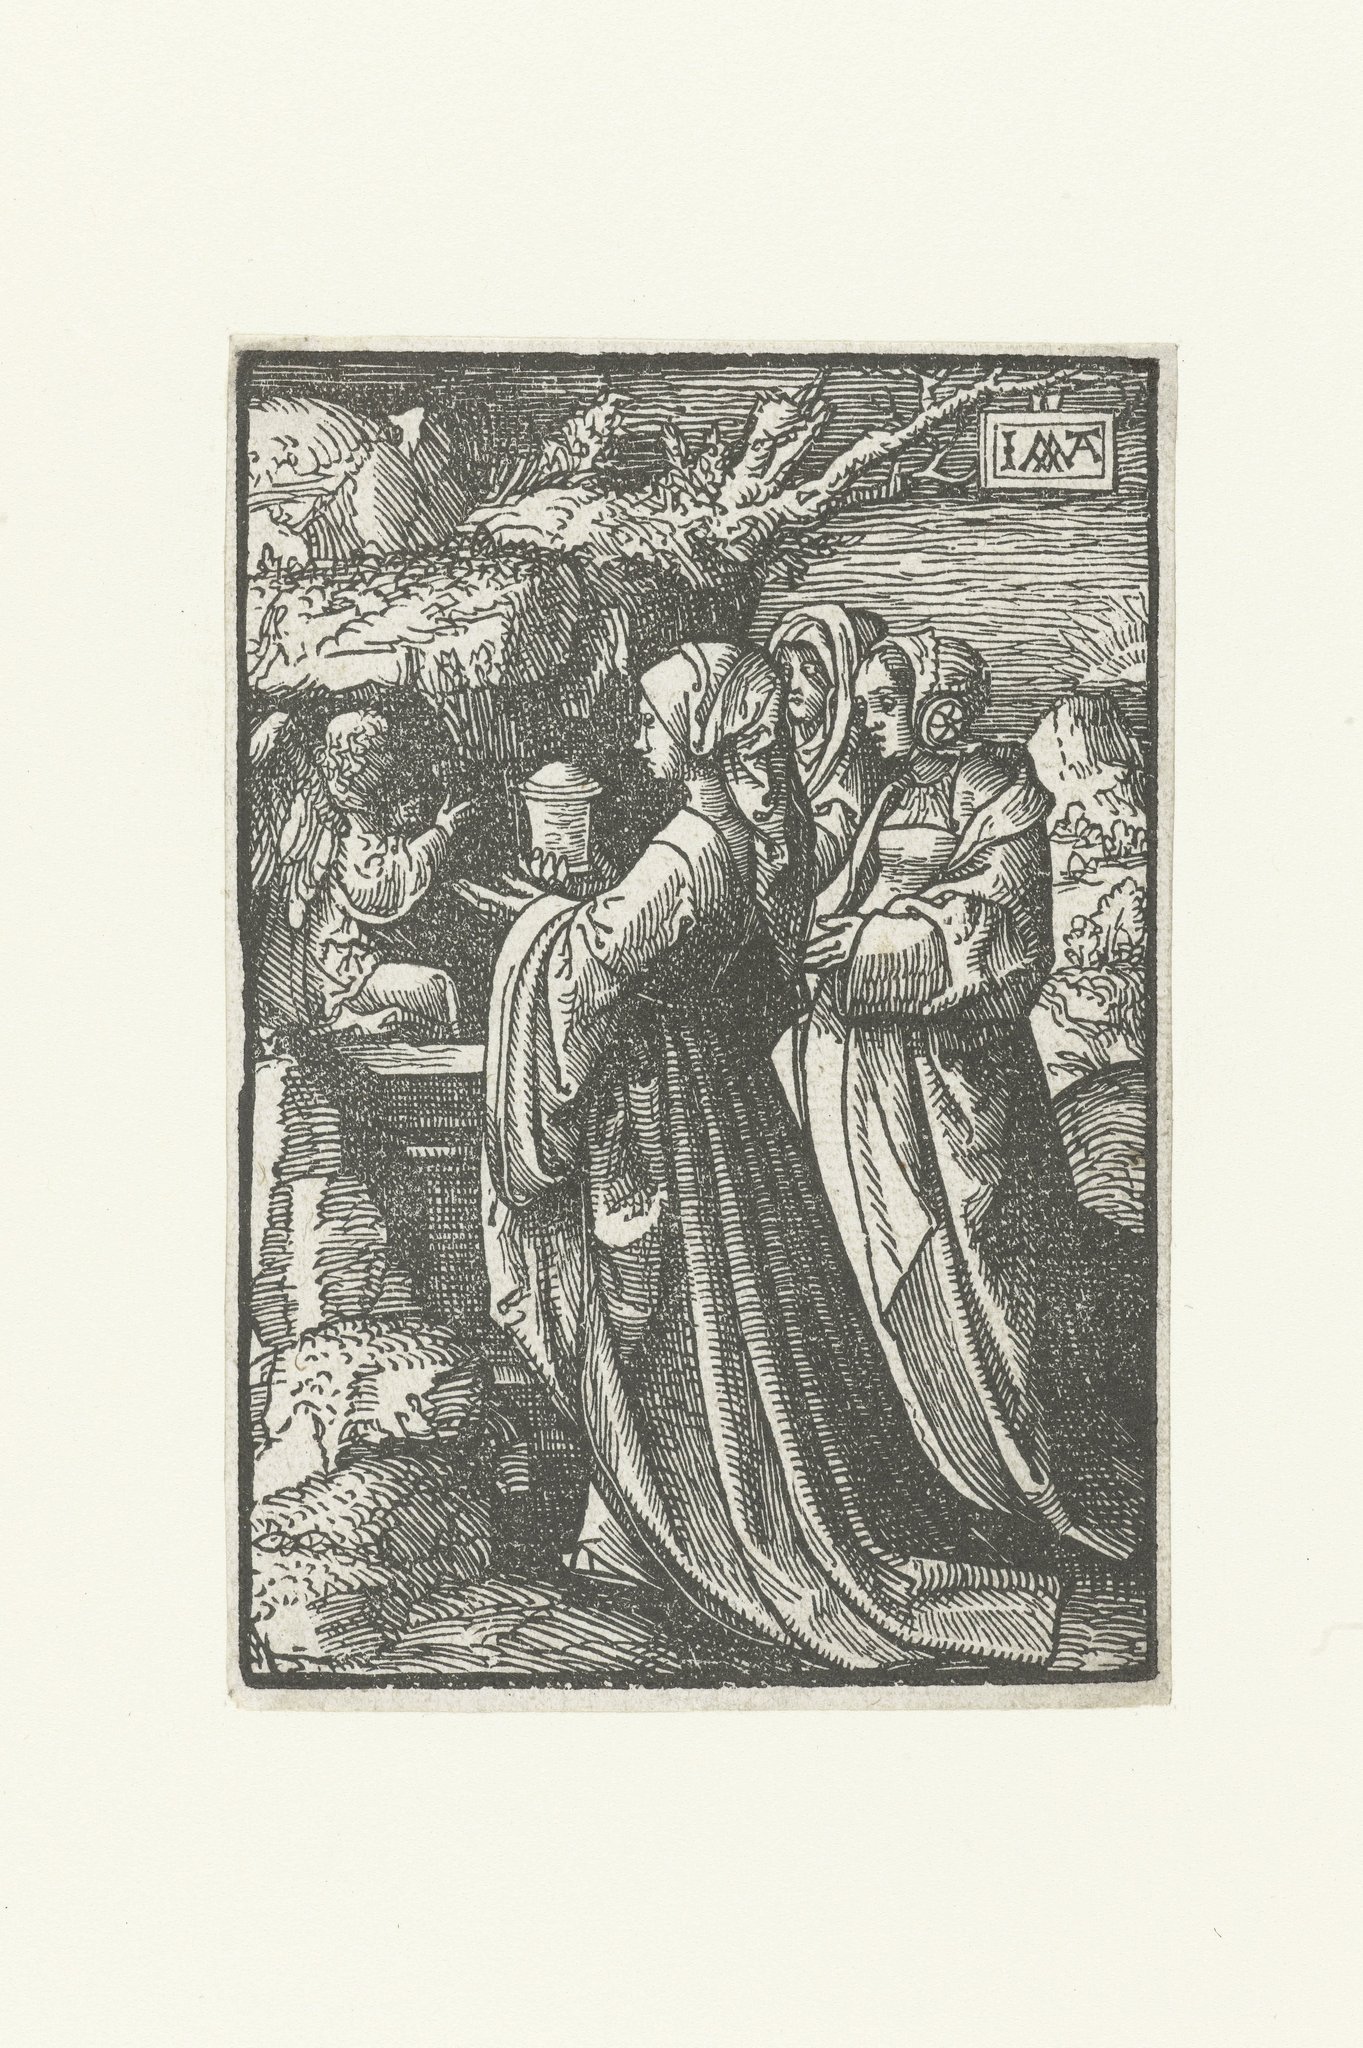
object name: print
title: De drie Maria's bij het lege graf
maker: jacob cornelisz van oostsanen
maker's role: draughtsman, painter, print maker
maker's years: 1475-1533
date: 1520-1521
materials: paper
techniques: woodcut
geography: low countries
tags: the holy women (the three maries) on their way to or at the tomb, to anoint christ's body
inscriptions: collector's mark: Lugt 2228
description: Uit serie van 66 prenten. Proefdruk, geen tekst op verso.